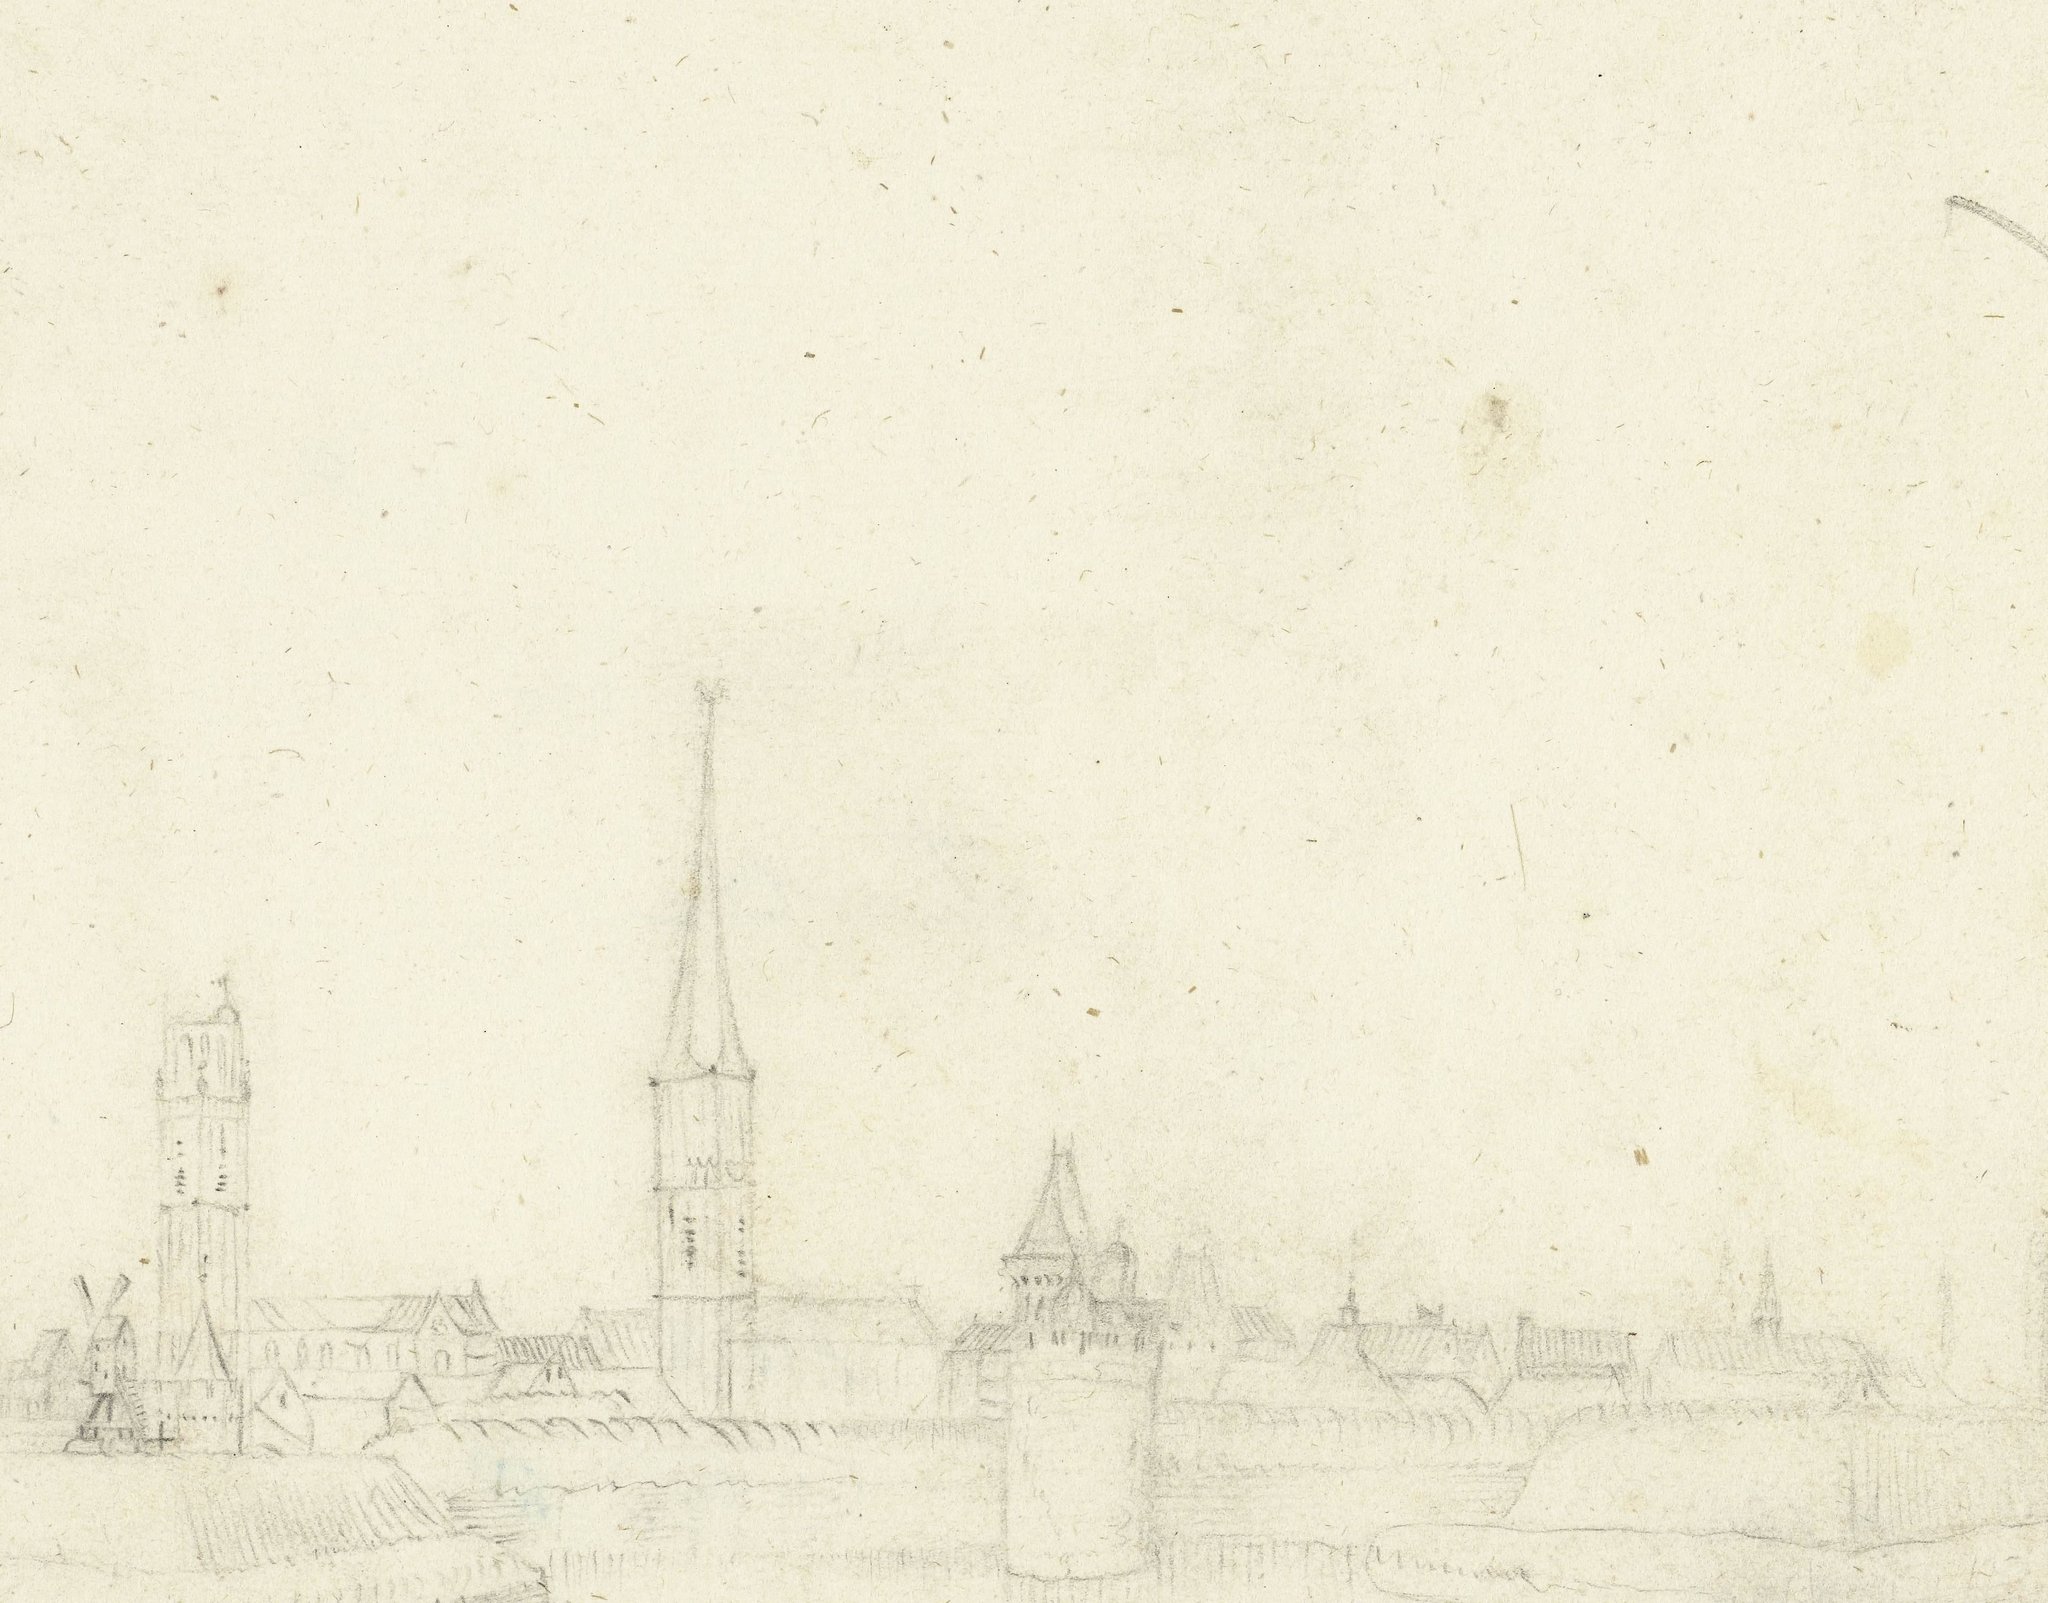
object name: drawing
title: Gezicht op Zwolle, vanuit het zuiden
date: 1647-1657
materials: paper, pencil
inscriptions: annotation: ‘Zwolle’